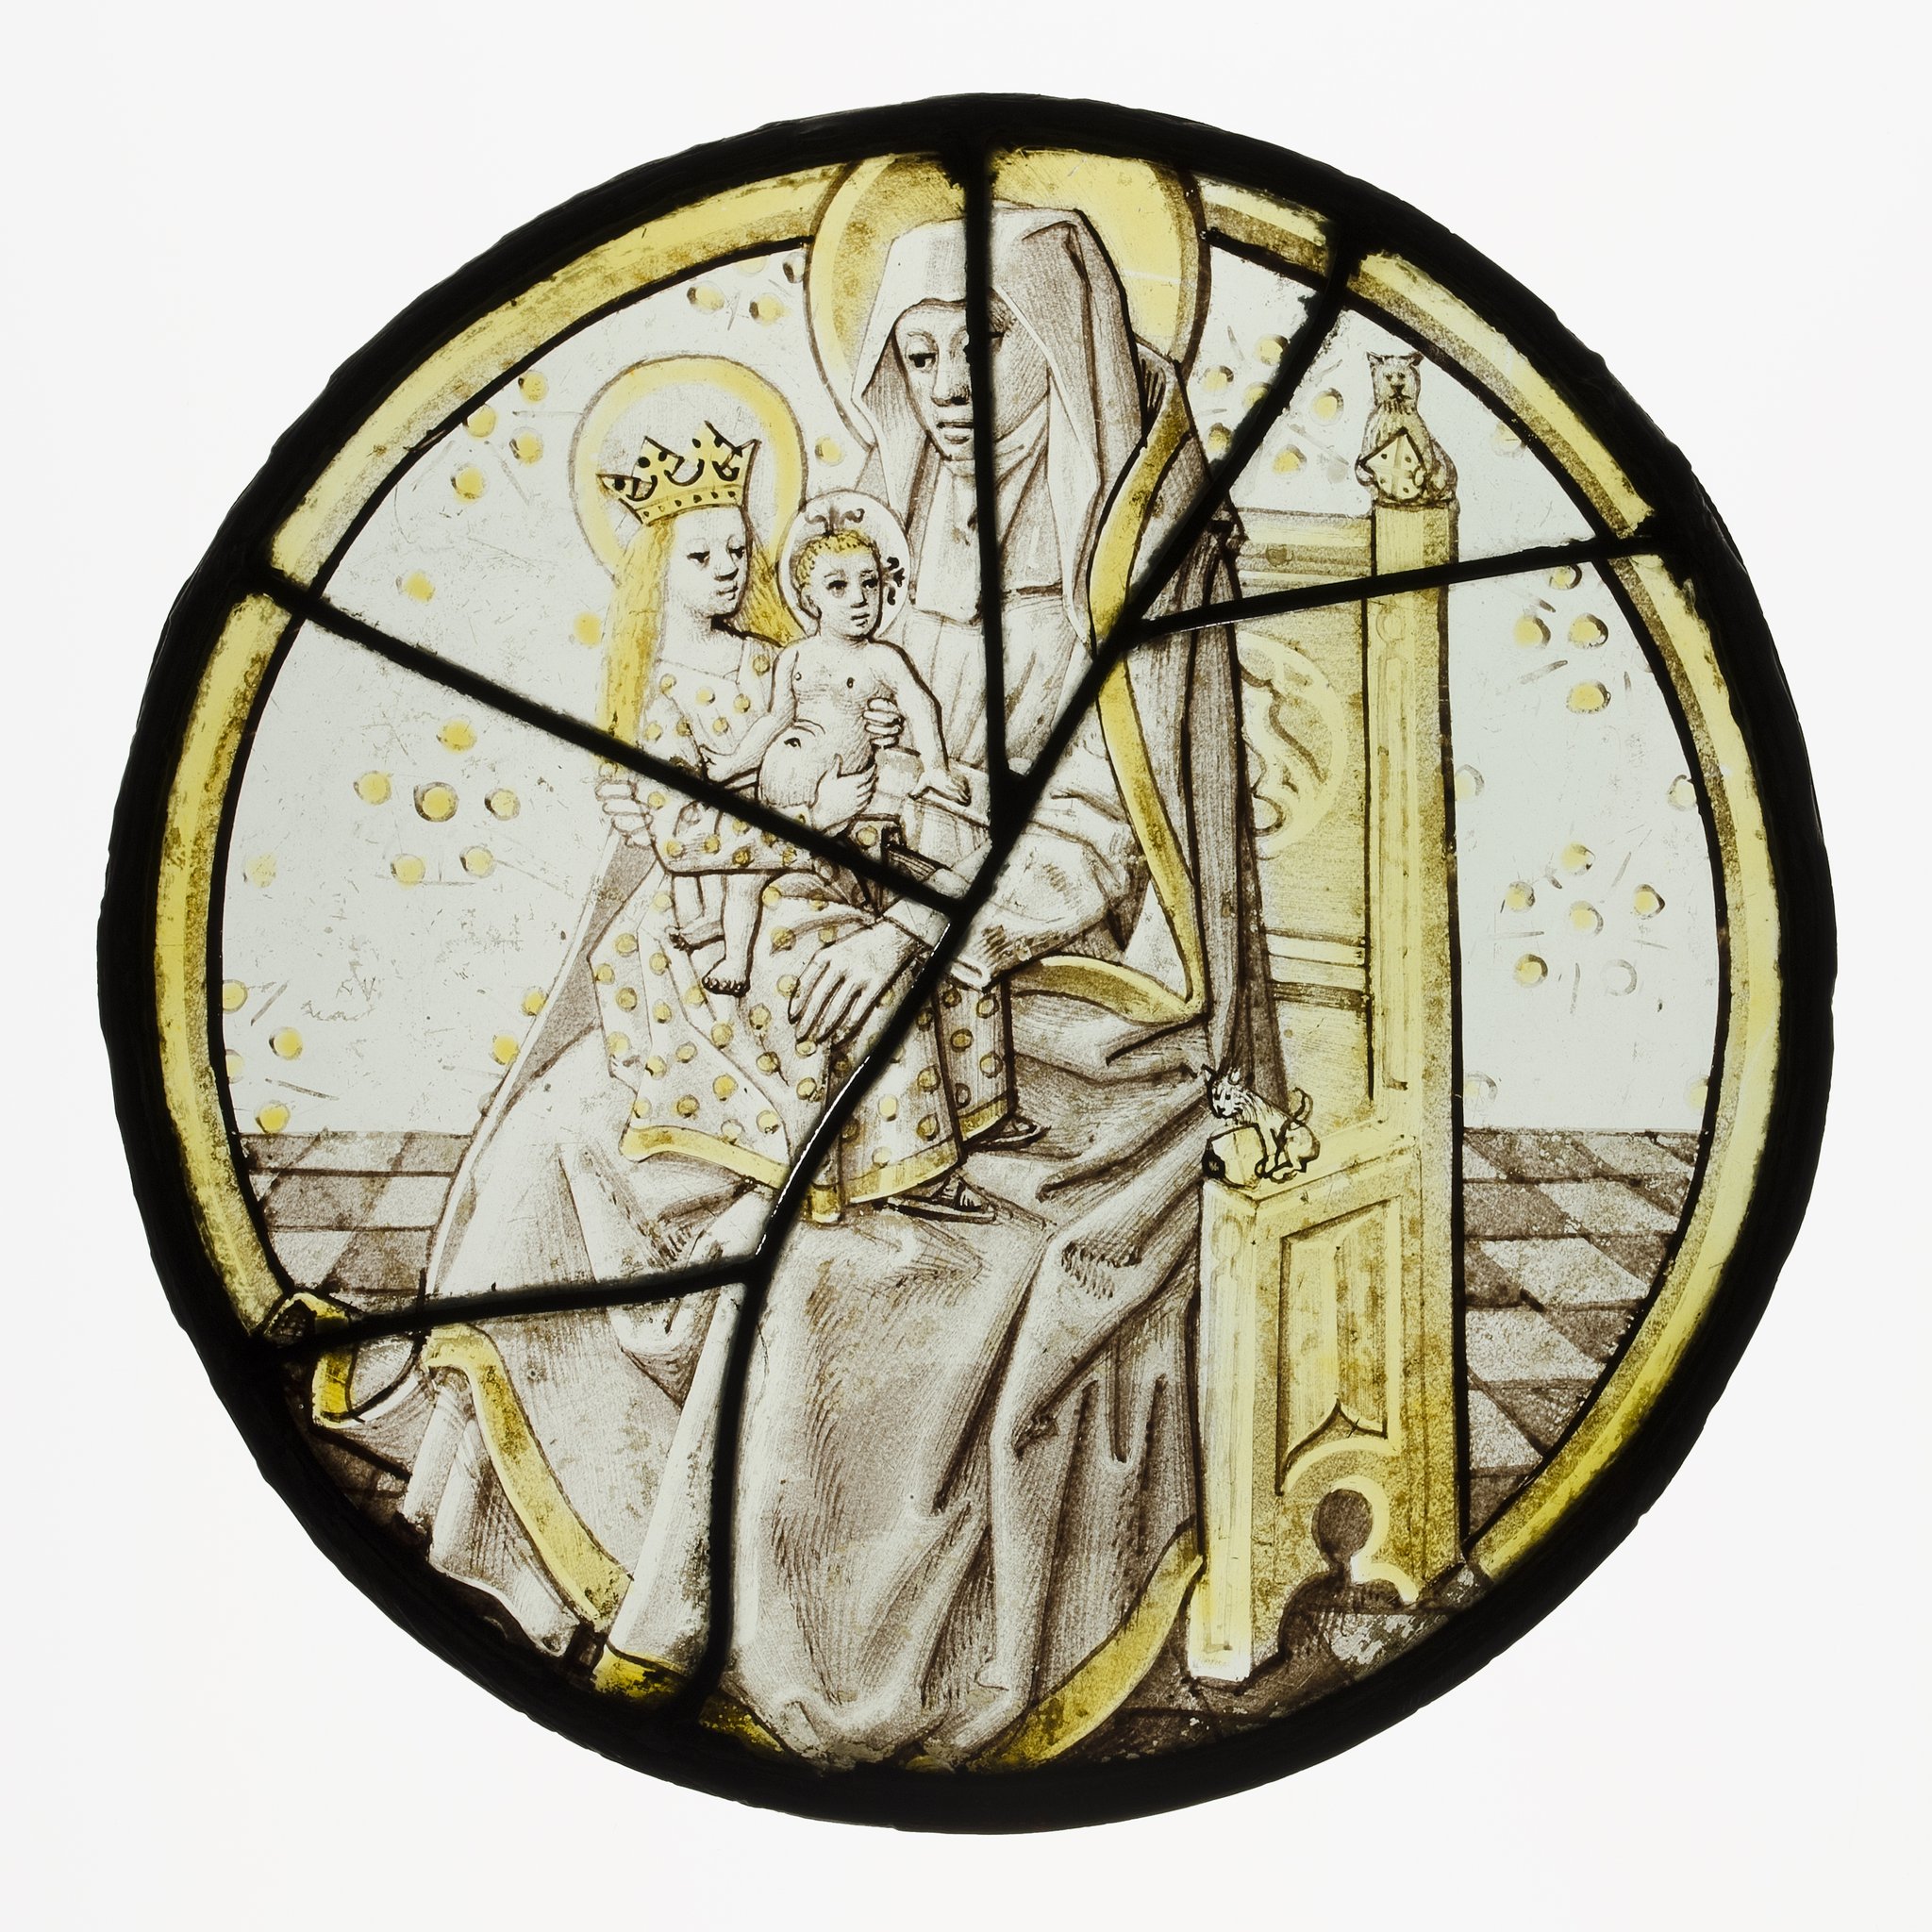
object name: roundel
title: Roundel with Saint Anne with the Virgin and Child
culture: south netherlandish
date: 1480-1500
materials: glass, paint, pigment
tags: madonna and child,saint anne